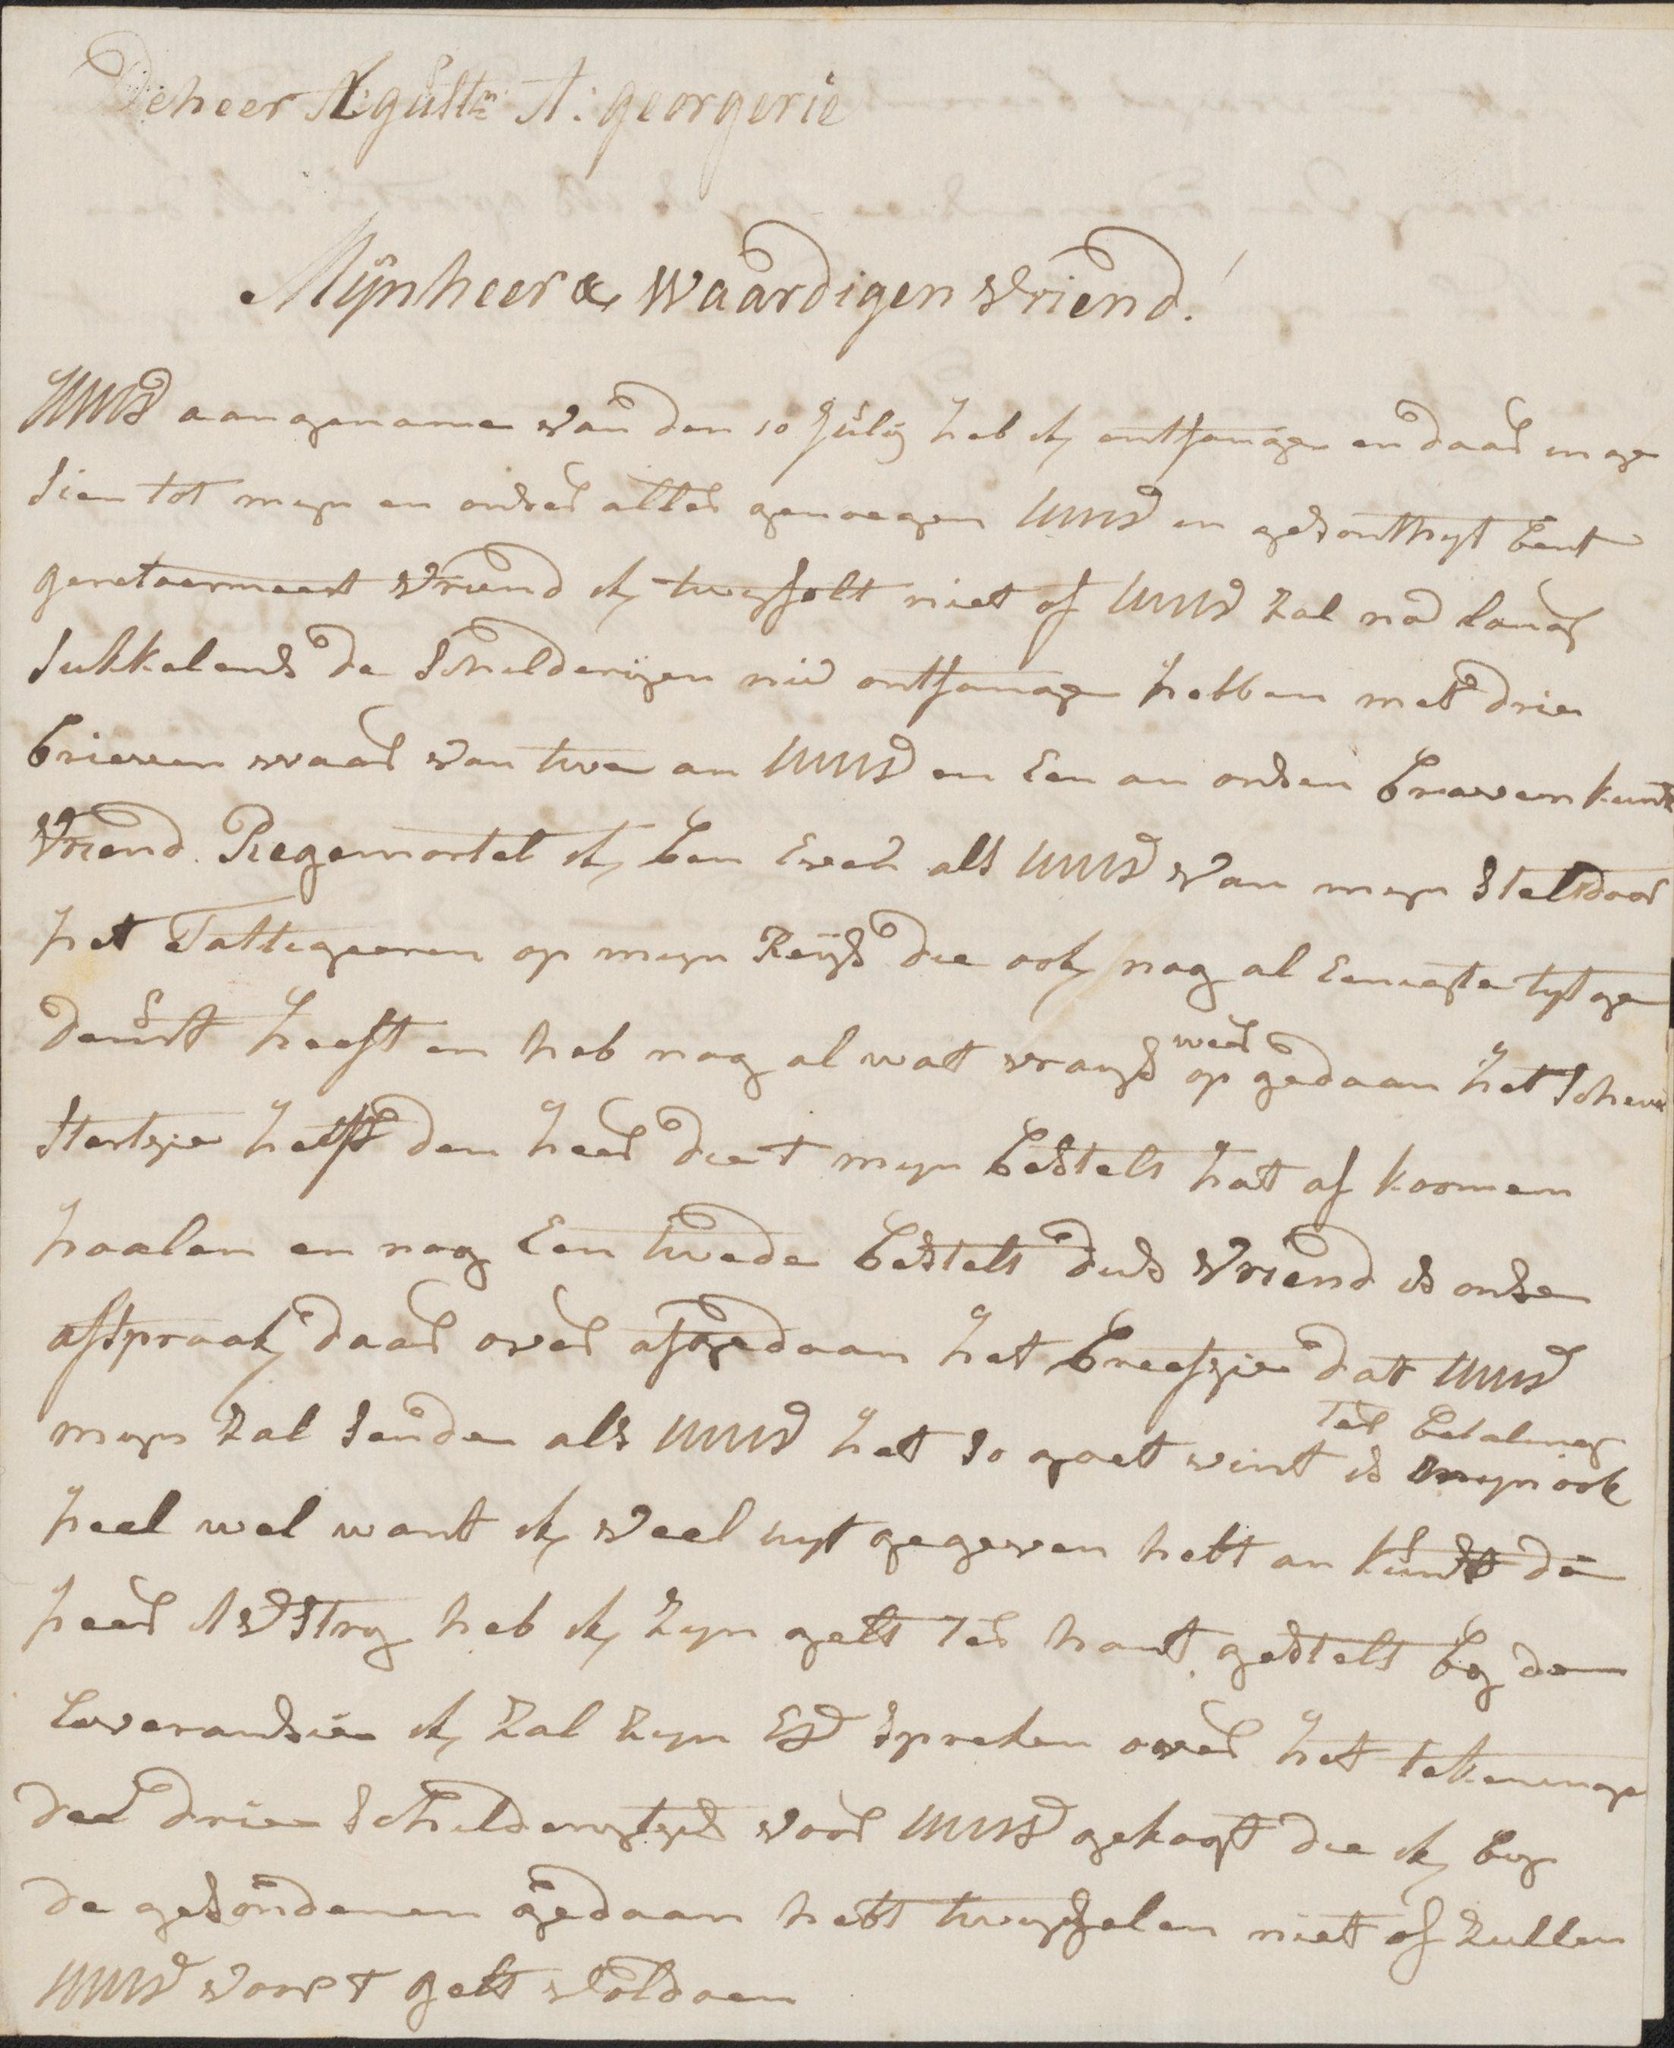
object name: letter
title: Brief aan A.A. Georgerie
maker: michiel versteegh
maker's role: painter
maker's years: 1756-1843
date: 1797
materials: ink, paper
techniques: pen, writing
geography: dordrecht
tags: money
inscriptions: watermark